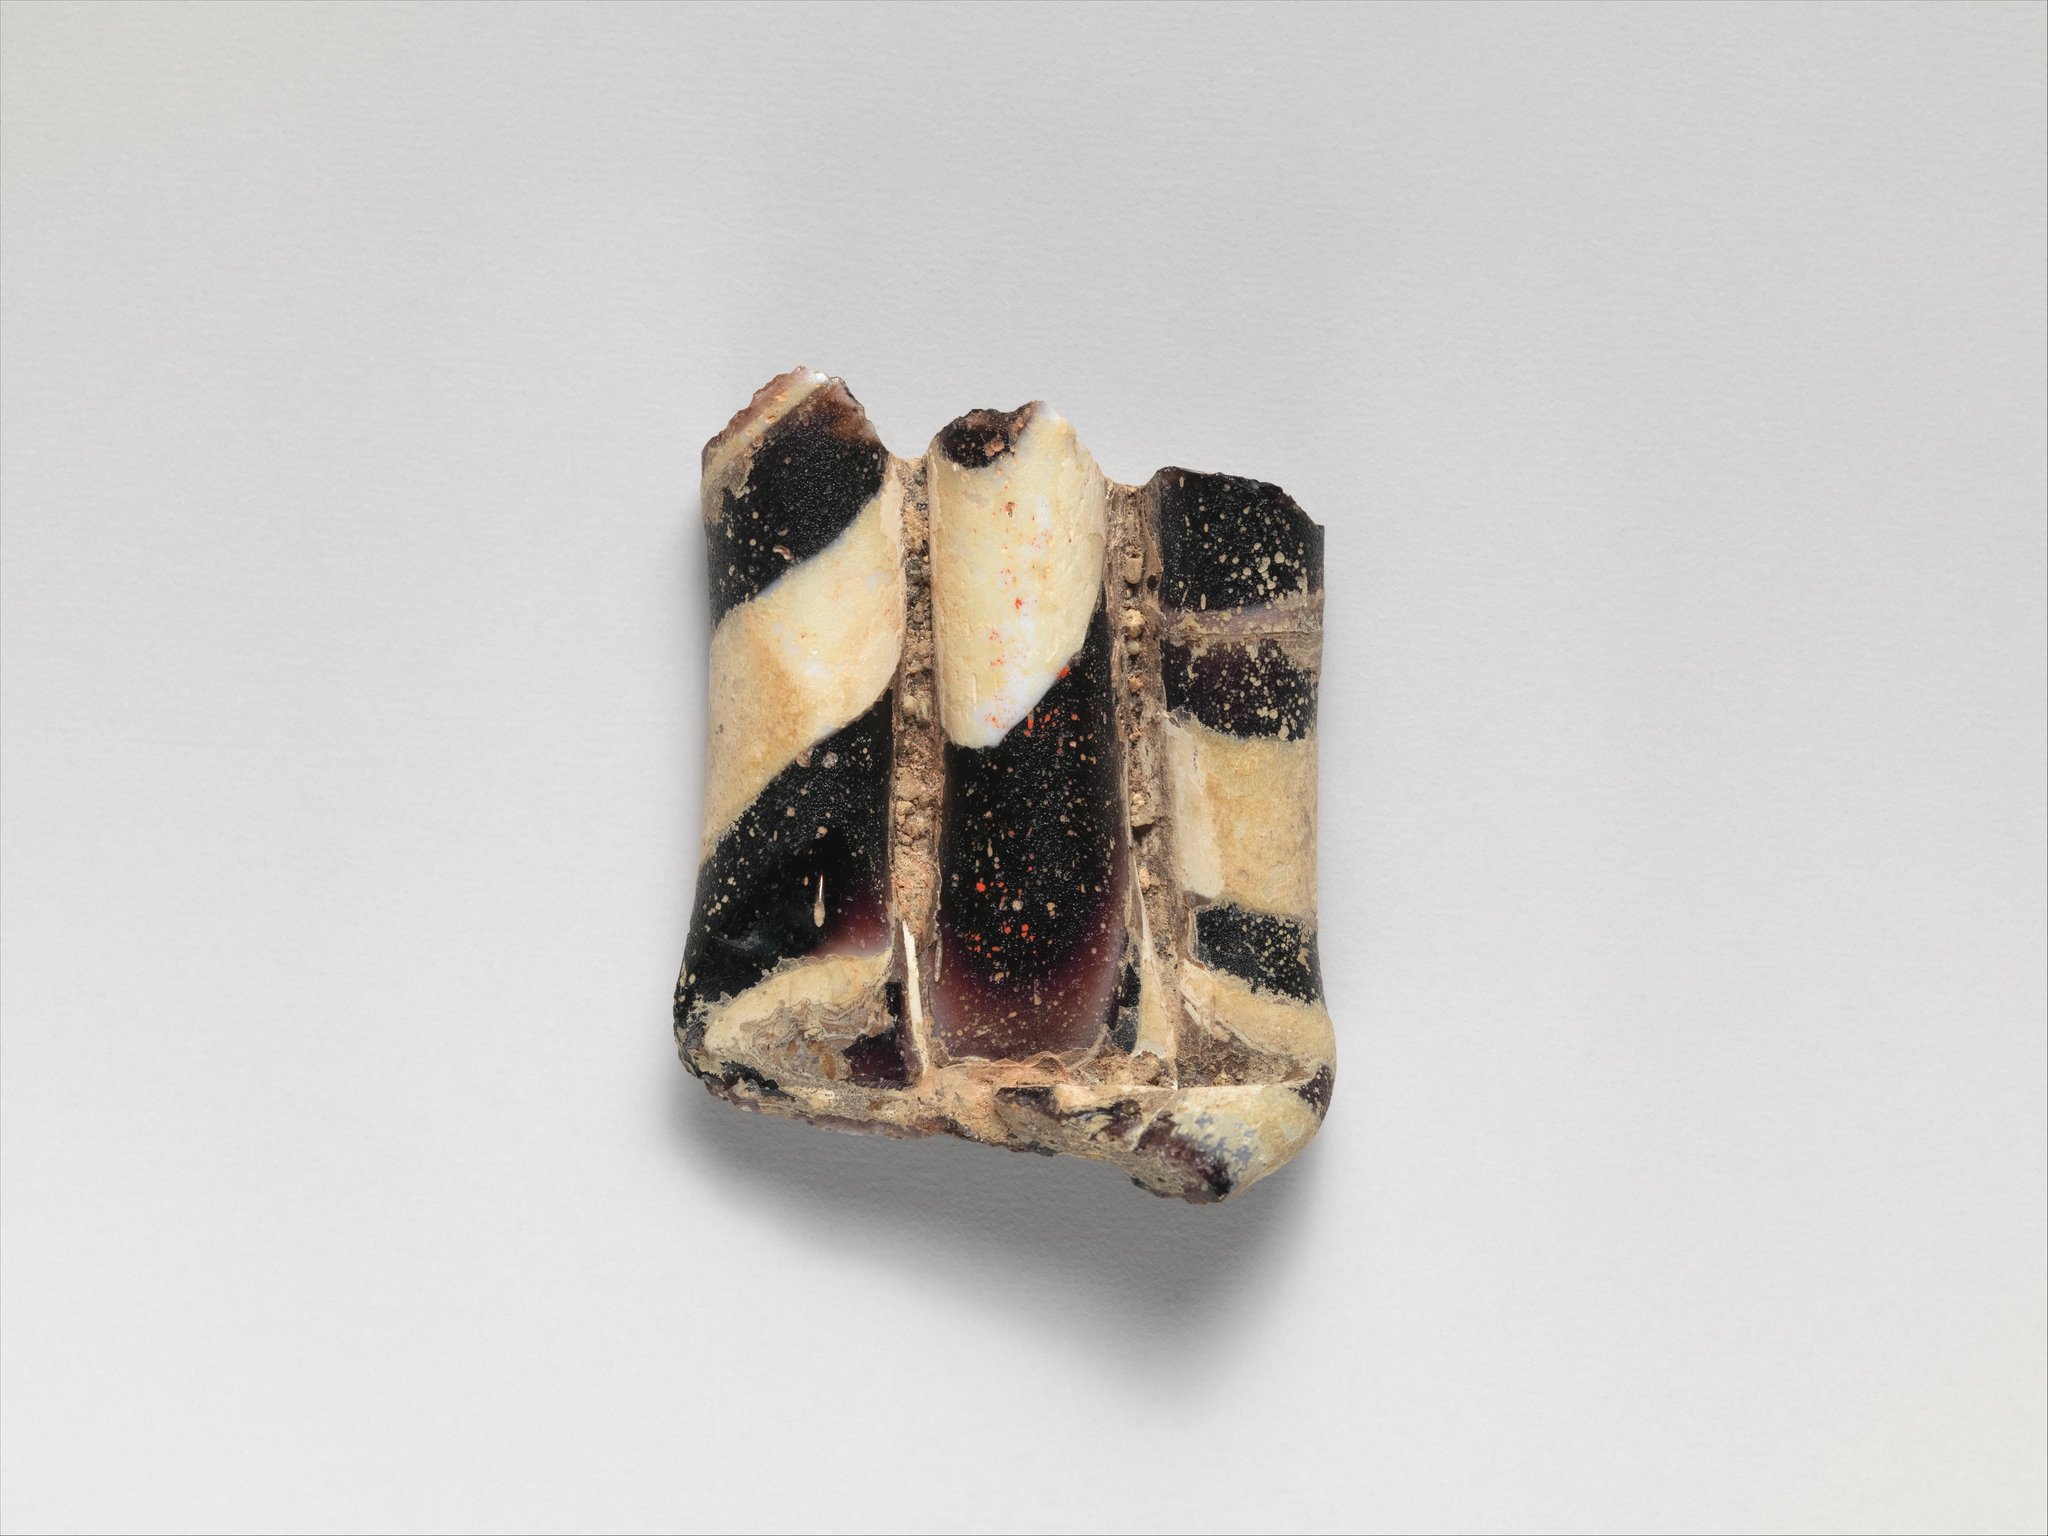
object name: fragment, mosaic handle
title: Glass mosaic handle fragment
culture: roman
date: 1-33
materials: glass